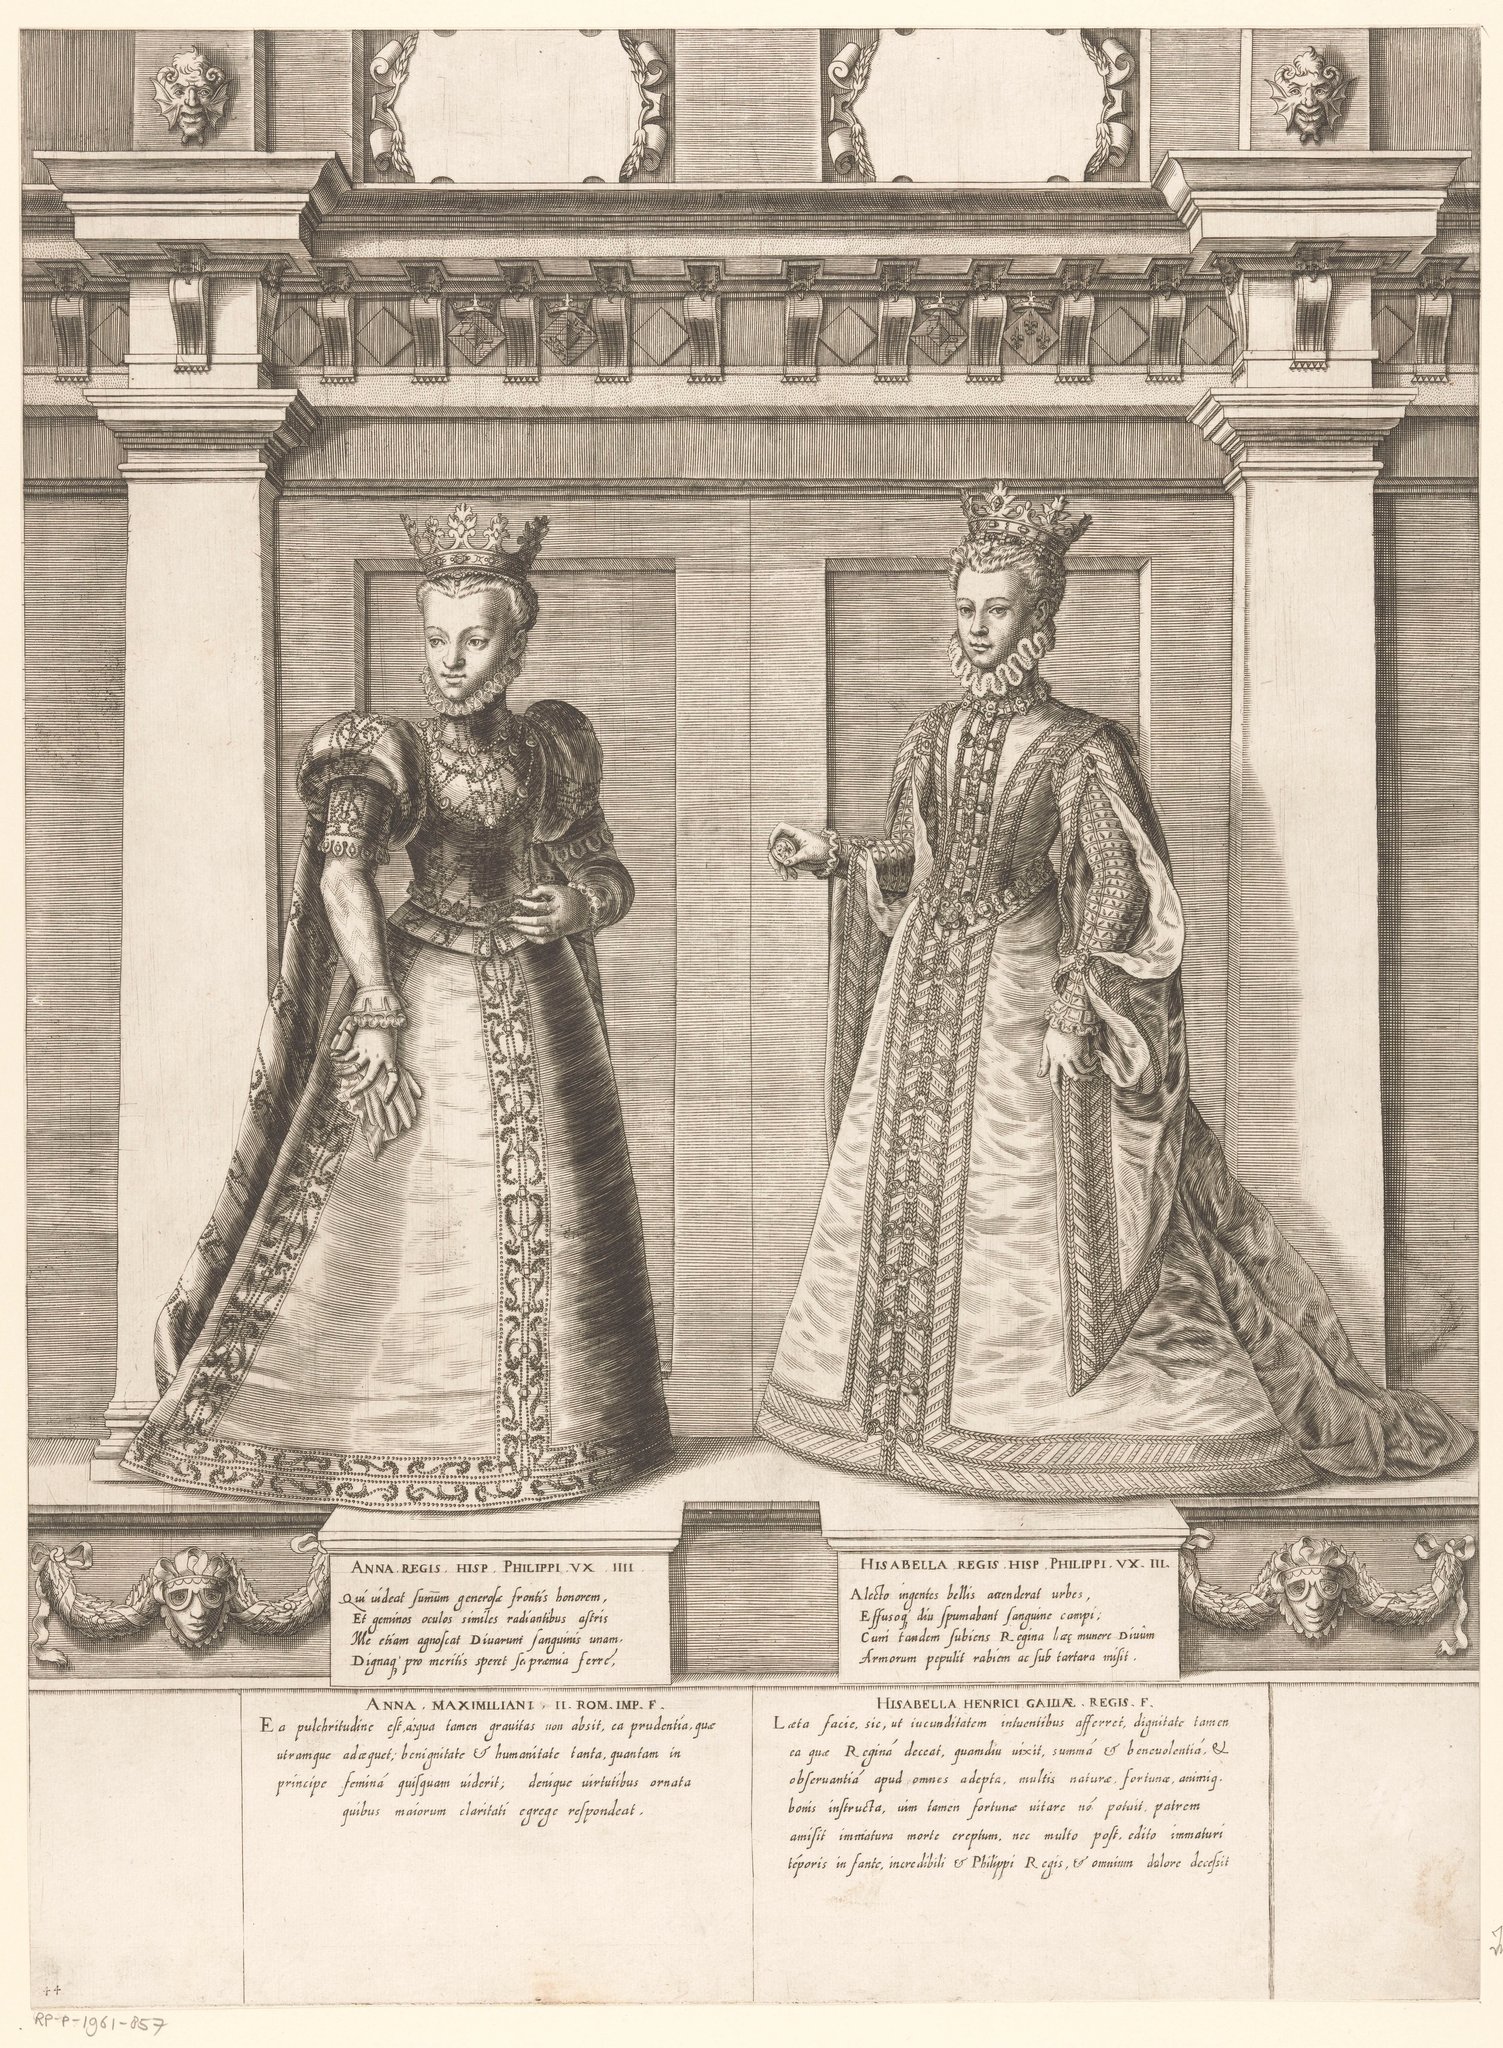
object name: print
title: Portretten van leden van het Oostenrijkse Huis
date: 1569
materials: paper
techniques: engraving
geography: italy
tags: infante van spanje isabella clara eugenia, historical persons - bb - woman, ruler, sovereign - bb - female ruler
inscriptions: collector's mark: Lugt 2228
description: Deze prent maakt deel uit van een reeks van 58 prenten. Het meerendeel van de prenten bevat portretten van 74 leden van het Oostenrijkse Huis, naar tekeningen door Francesco Terzio, die deels getekend zijn naar de 28 levensgrote bronzen beelden die rond de cenotaaf van Maximiliaan I in de Hofkirche te Innsbruck staan. Op het object staat nummer 44, maar in de literatuur wordt de prent genoemd als prent 45 uit de reeks.